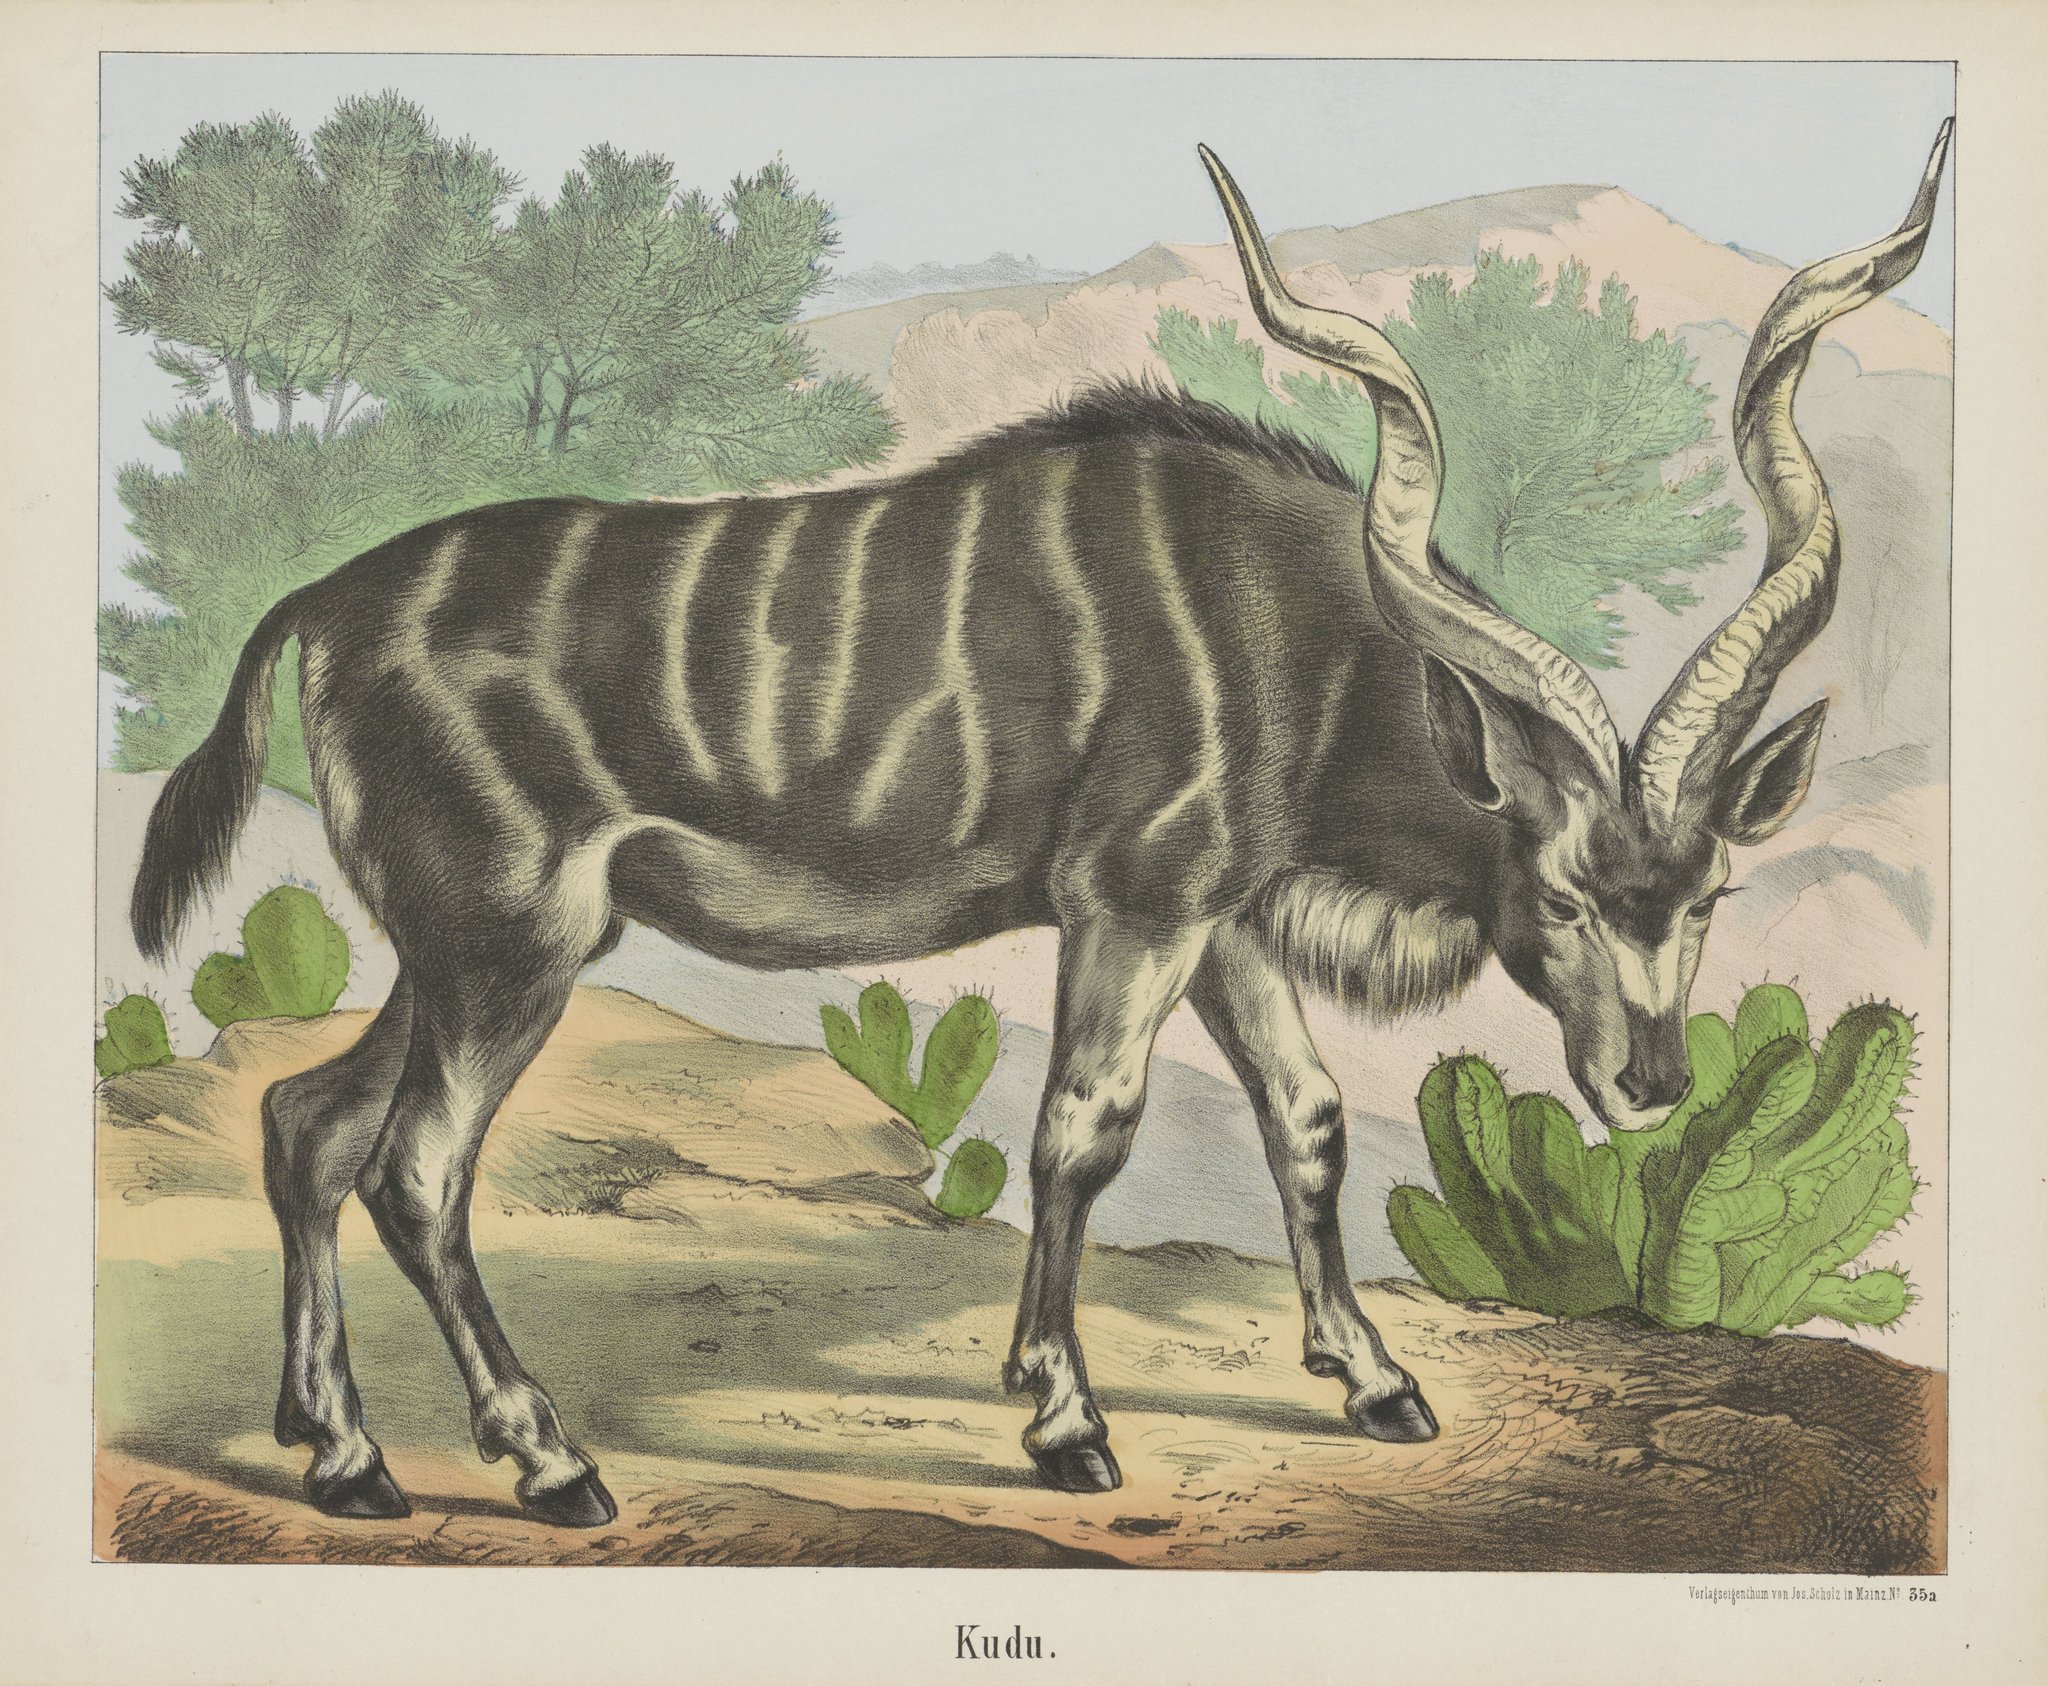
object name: print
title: Kudu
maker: Anonymous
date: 1829-1880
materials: paper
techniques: colour, letterpress printing, lithograph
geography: europe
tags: hoofed animals: antelope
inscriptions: collector's mark: Lugt 2760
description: Een koedoe in een berglandschap met cactussen. Genummerd rechtsonder: No. 35a.